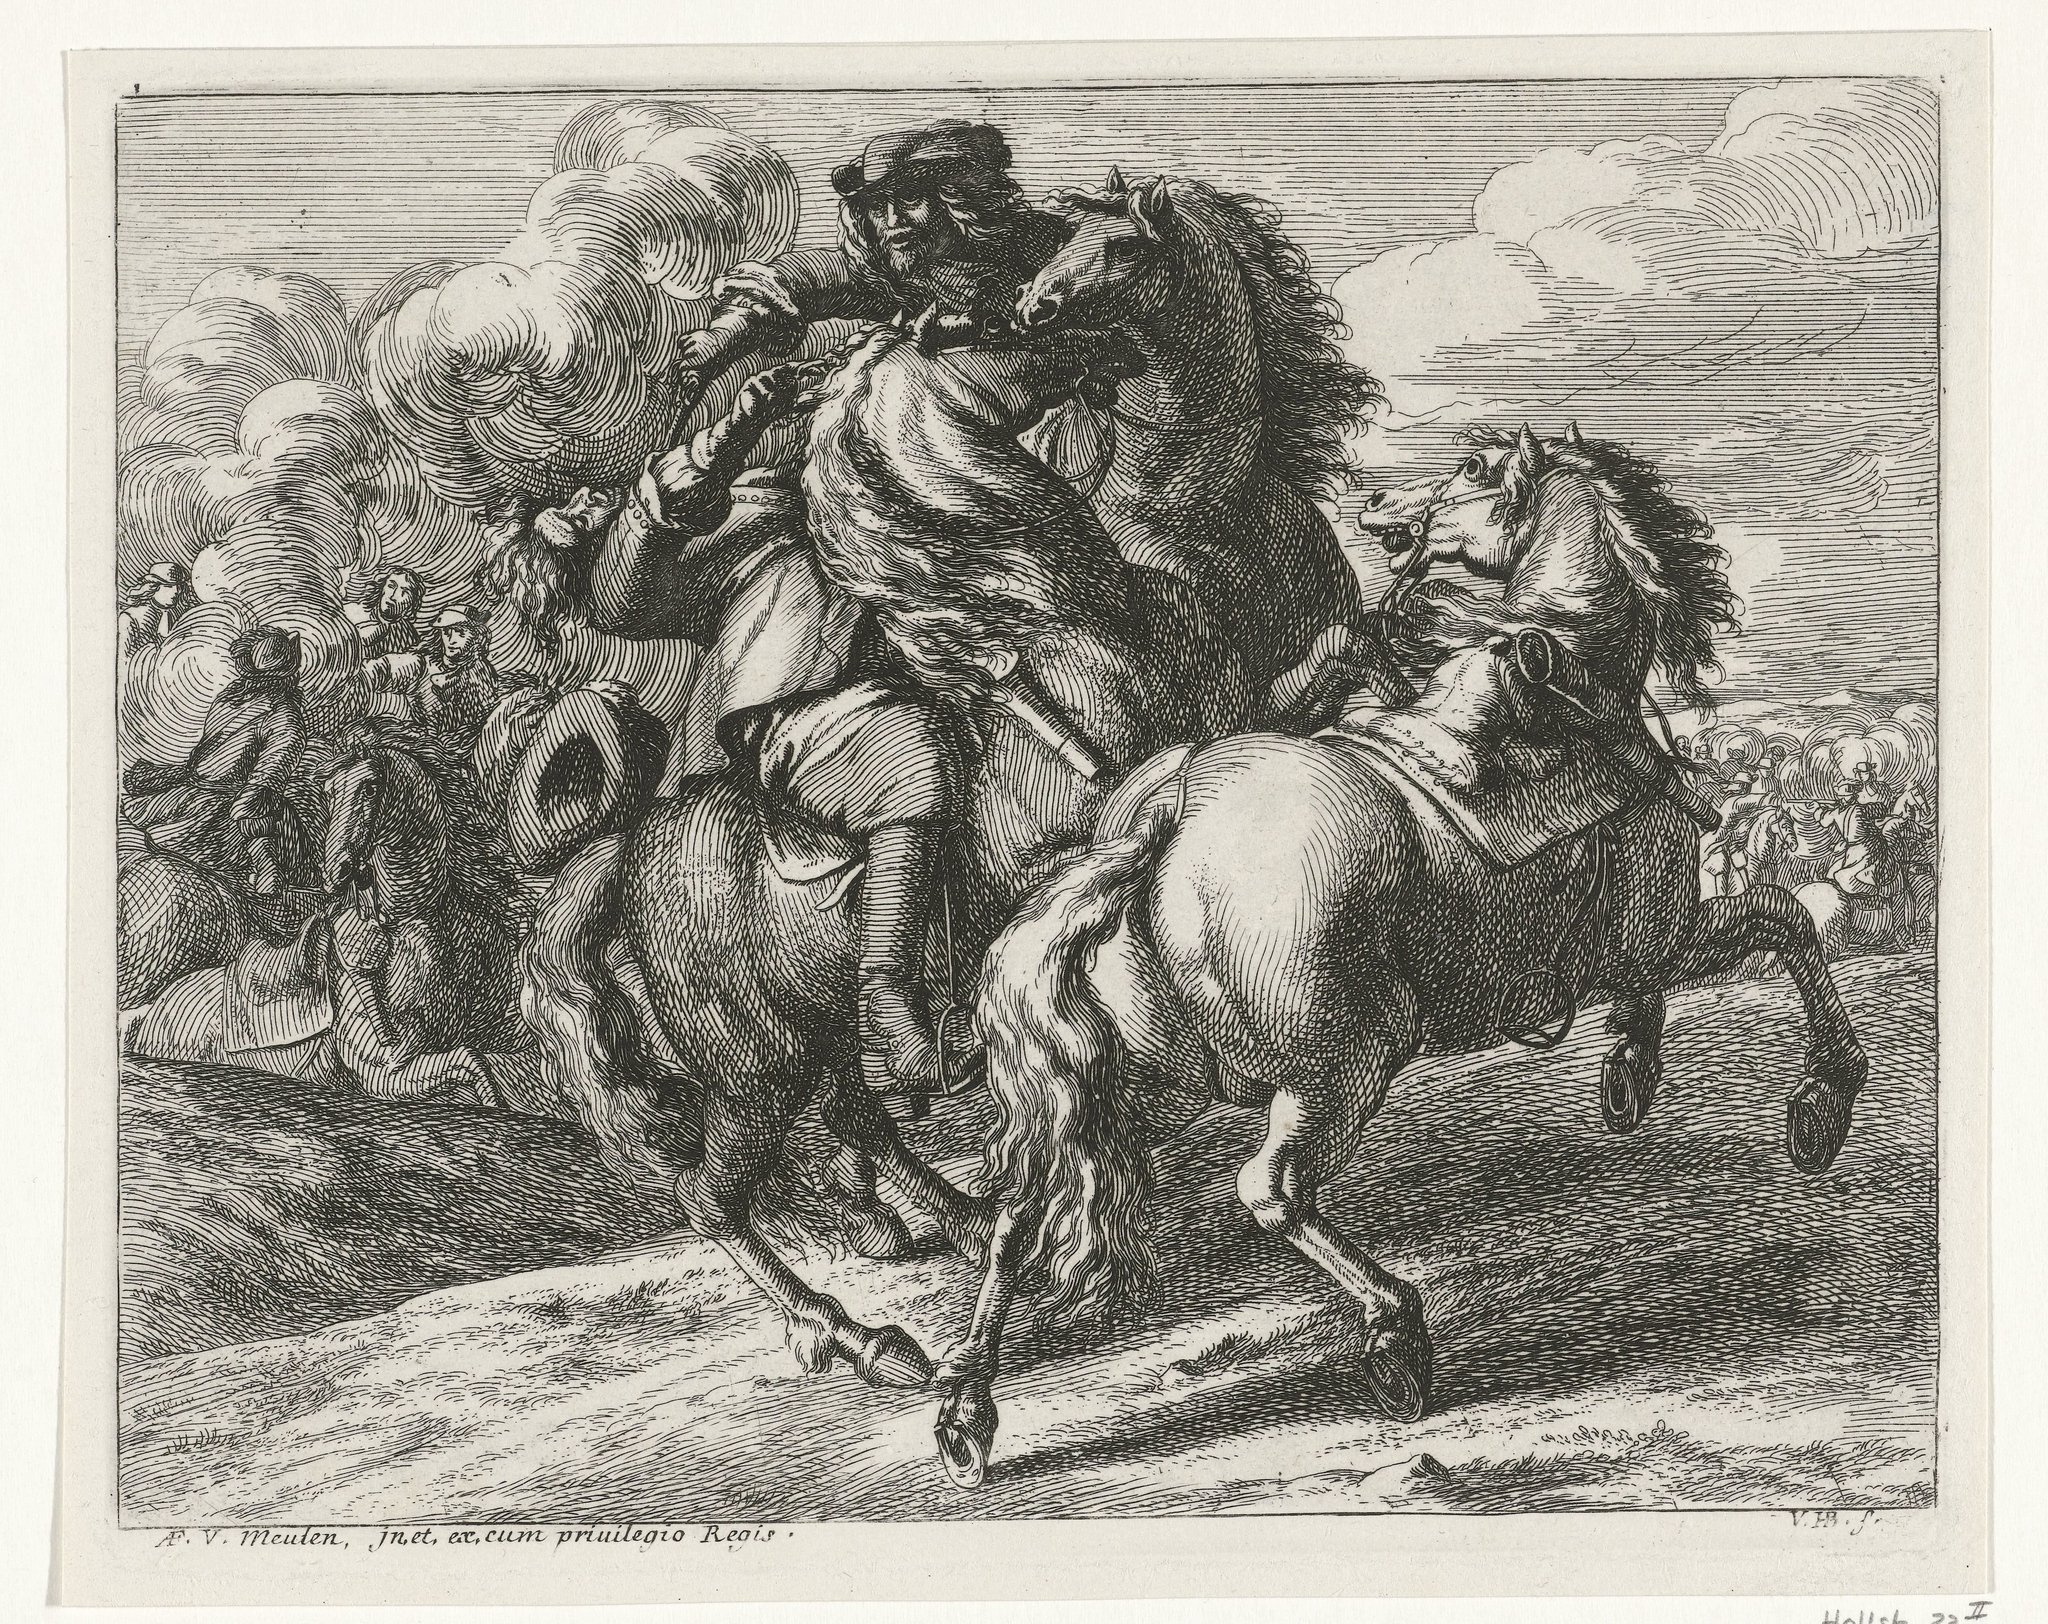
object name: print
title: Cavaleriescènes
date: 1674-1733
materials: paper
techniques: engraving, etching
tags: war and peace (+ cavalry, horsemen)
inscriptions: collector's mark: Lugt 2228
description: Een ruiter schiet met een pistool een andere ruiter, wiens hoed afvalt, neer. Voor hen langs galoppeert een paard dat zijn berijder verloren heeft.